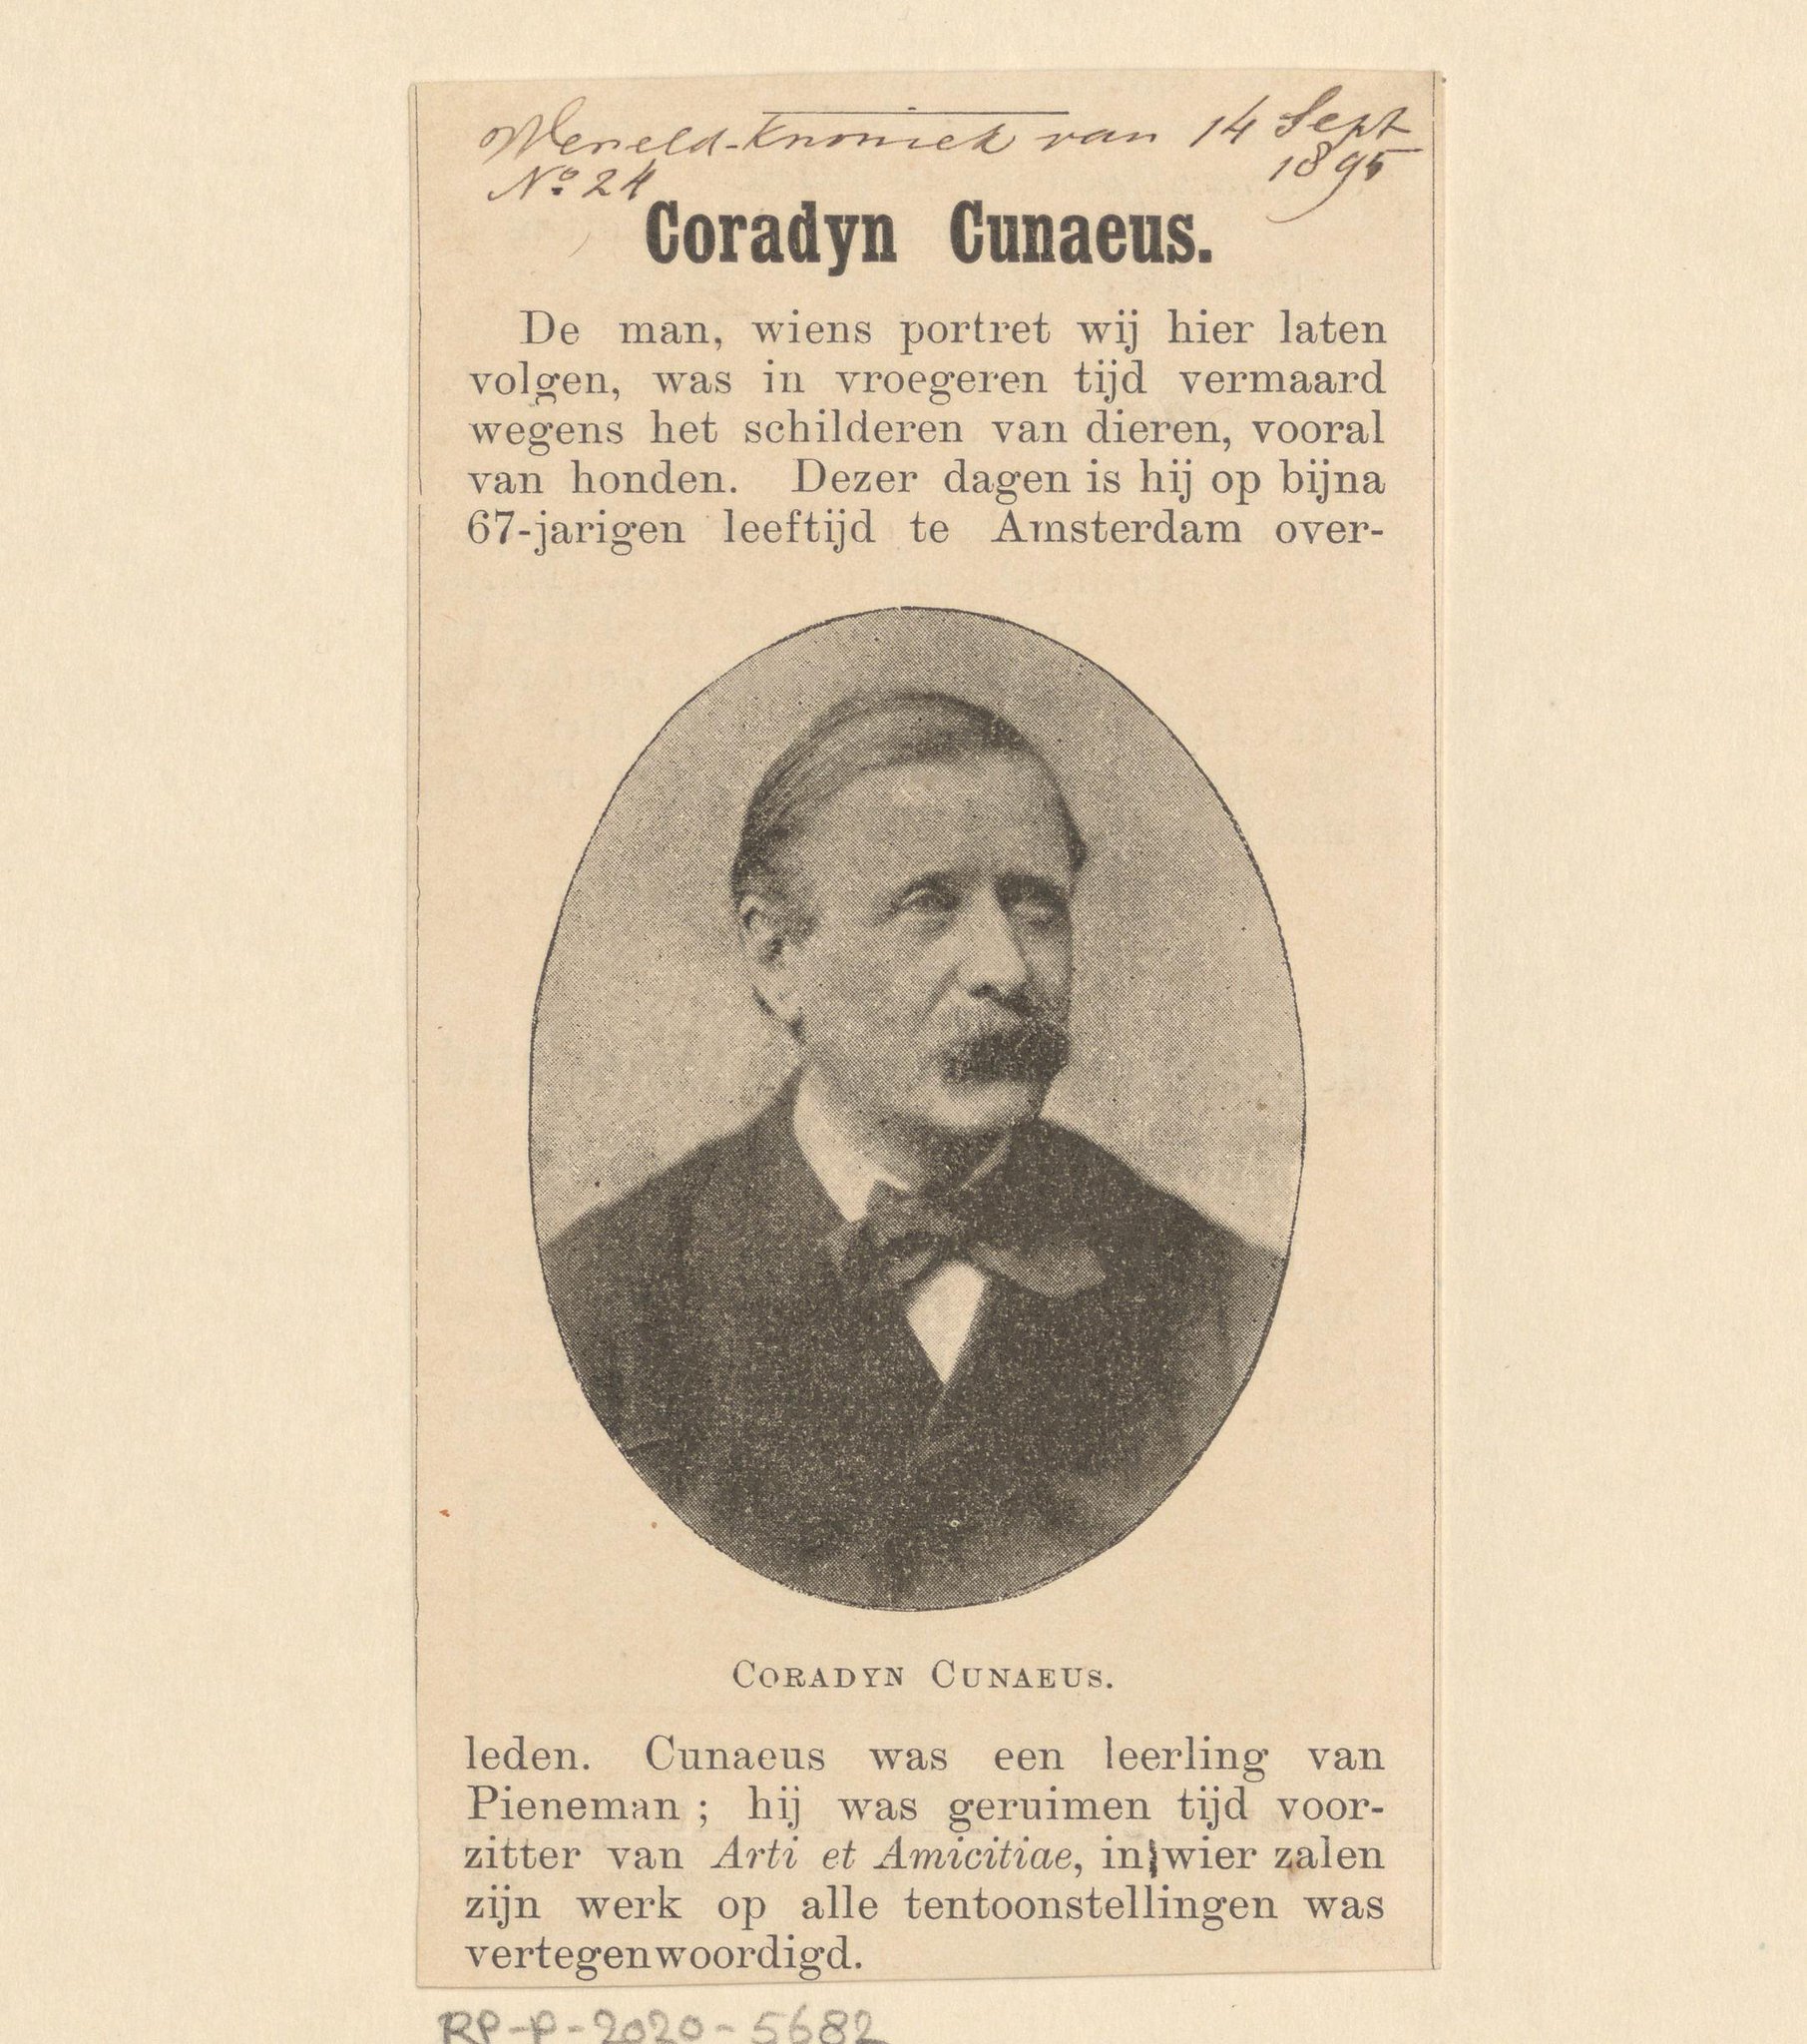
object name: photomechanical print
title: Portret van Conradijn Cunaeus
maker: Anonymous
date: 1895-1896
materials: paper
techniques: letterpress printing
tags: conradijn cunaeus, historical persons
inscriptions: collector's mark: Lugt 2228, collector's mark: Lugt 2760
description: Prent mogelijk uit: Wereldkroniek, nr. 24, 24 september 1895.